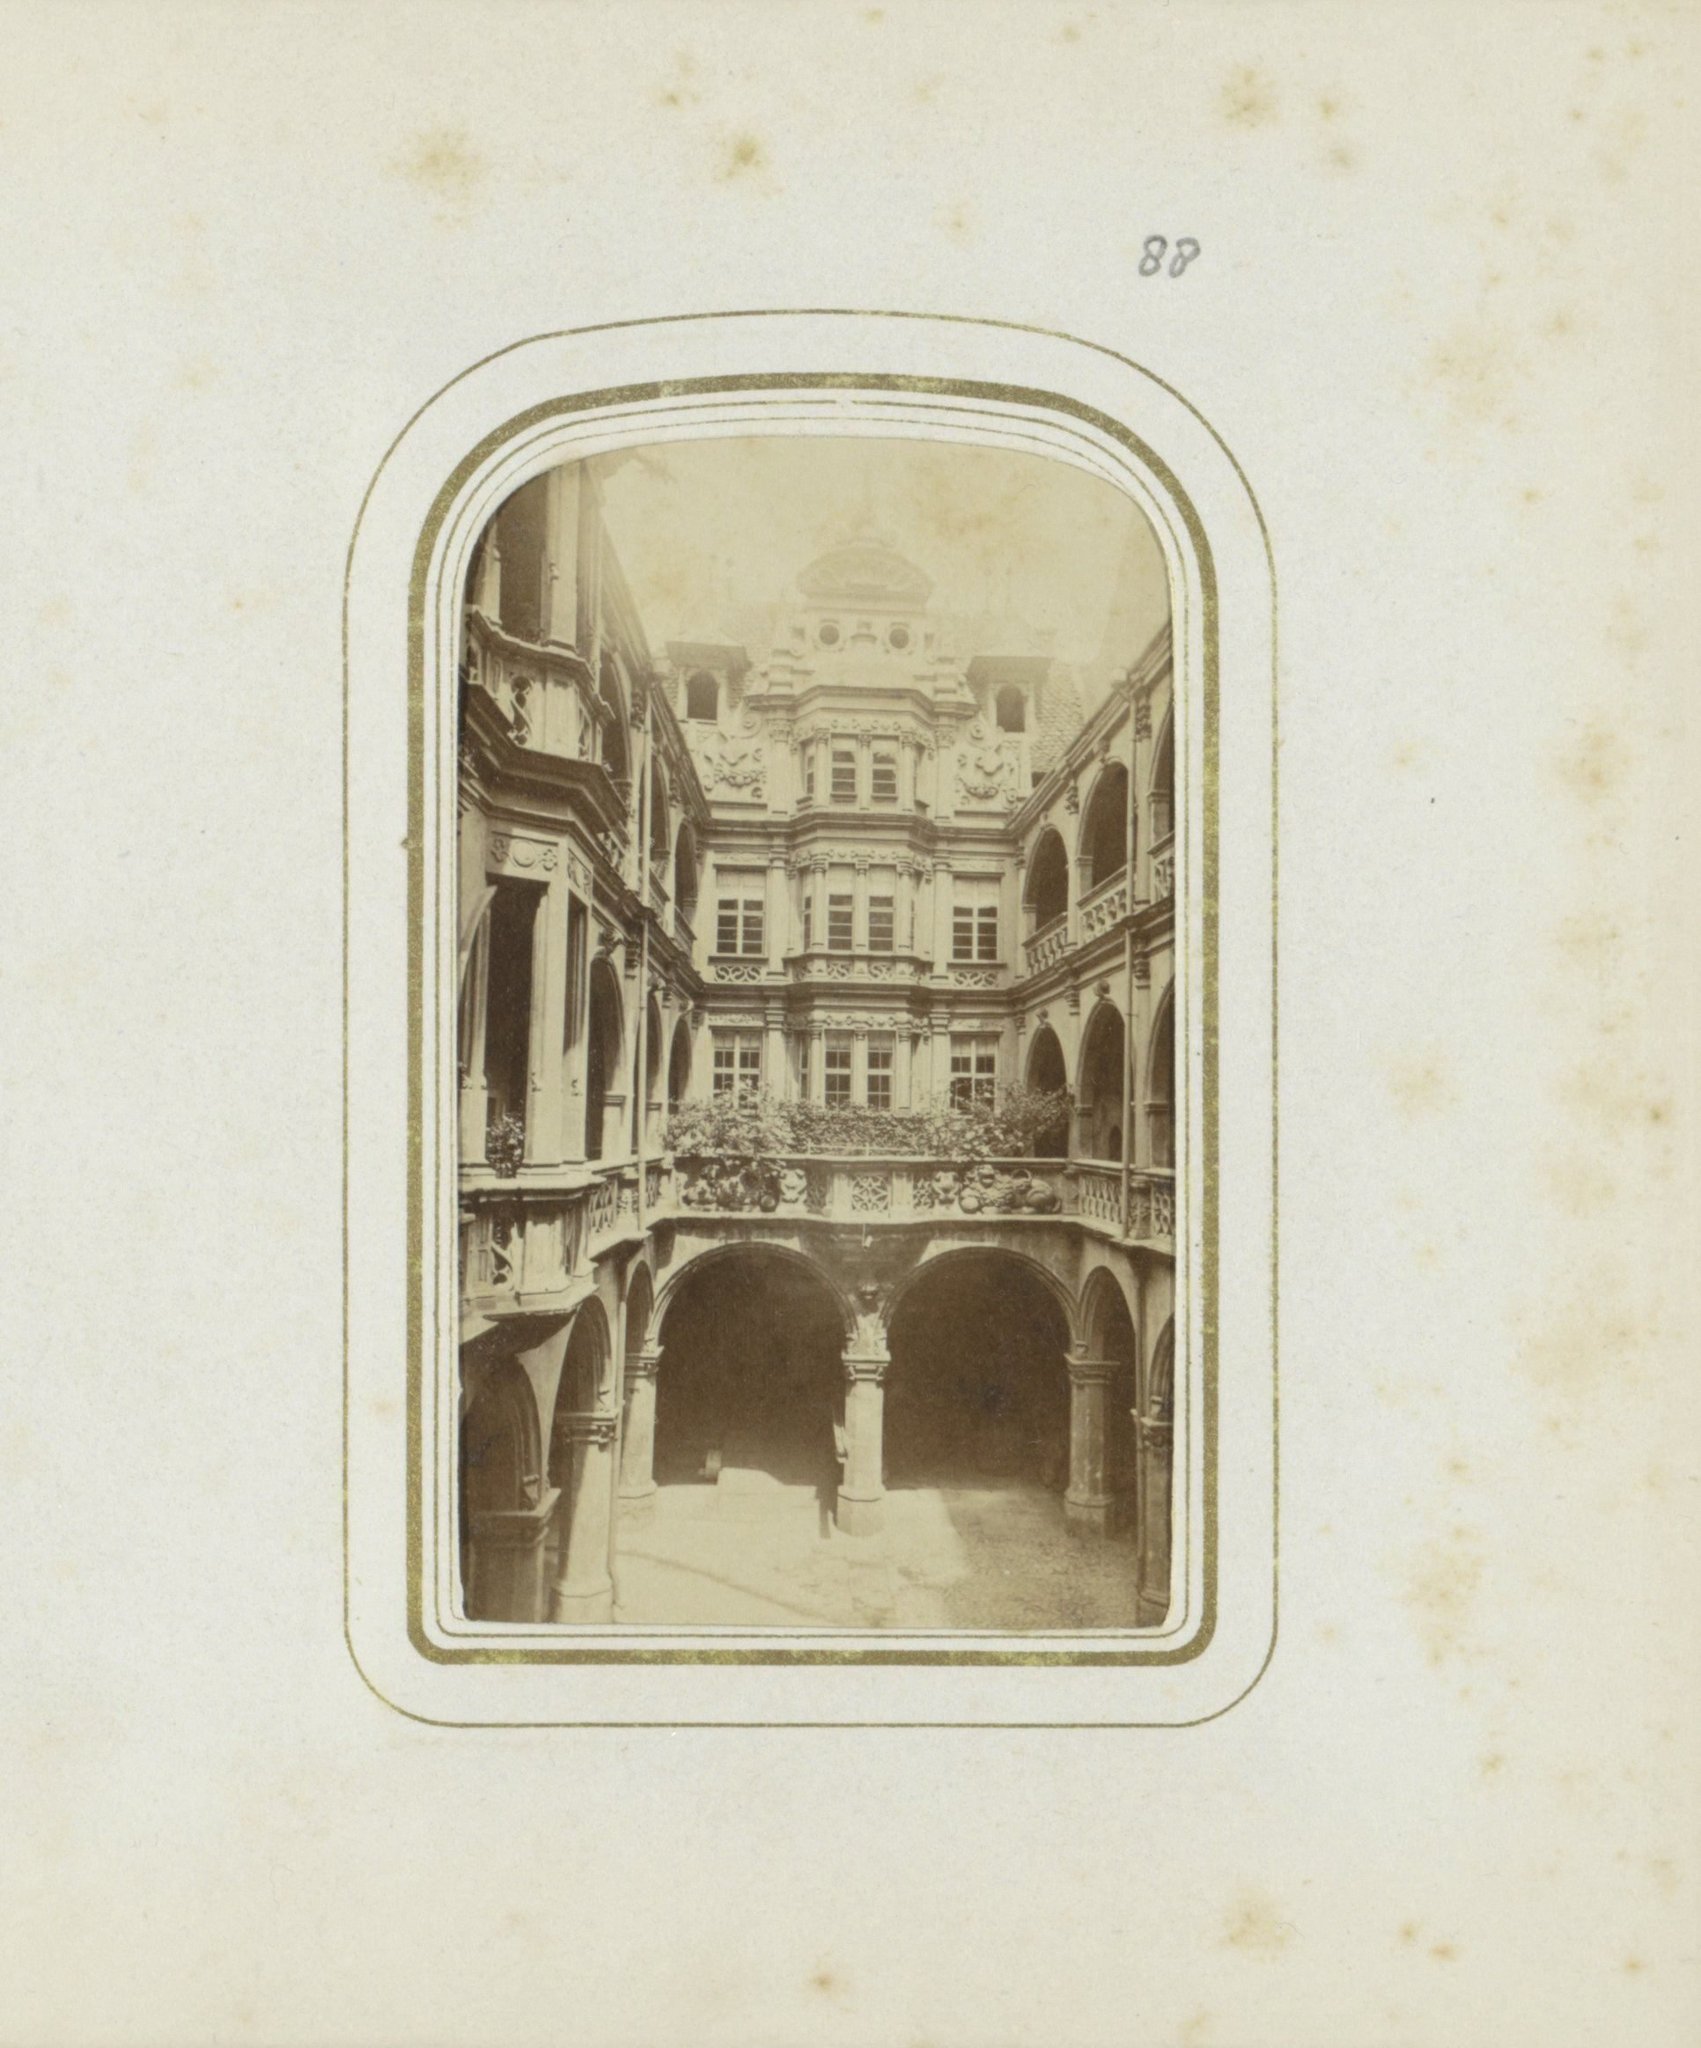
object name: photograph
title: Woonhuis met geornamenteerde gevel en portieken in Neurenberg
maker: Anonymous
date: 1865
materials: paper, photographic support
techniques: albumen print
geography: nuremberg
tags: travelling; tourism, façade (of house or building), loggia, verandah, porch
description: Onderdeel van Fotoalbum van een reis door Zwitserland, Oostenrijk en Duitsland door de Nederlandse familie Derkinderen.